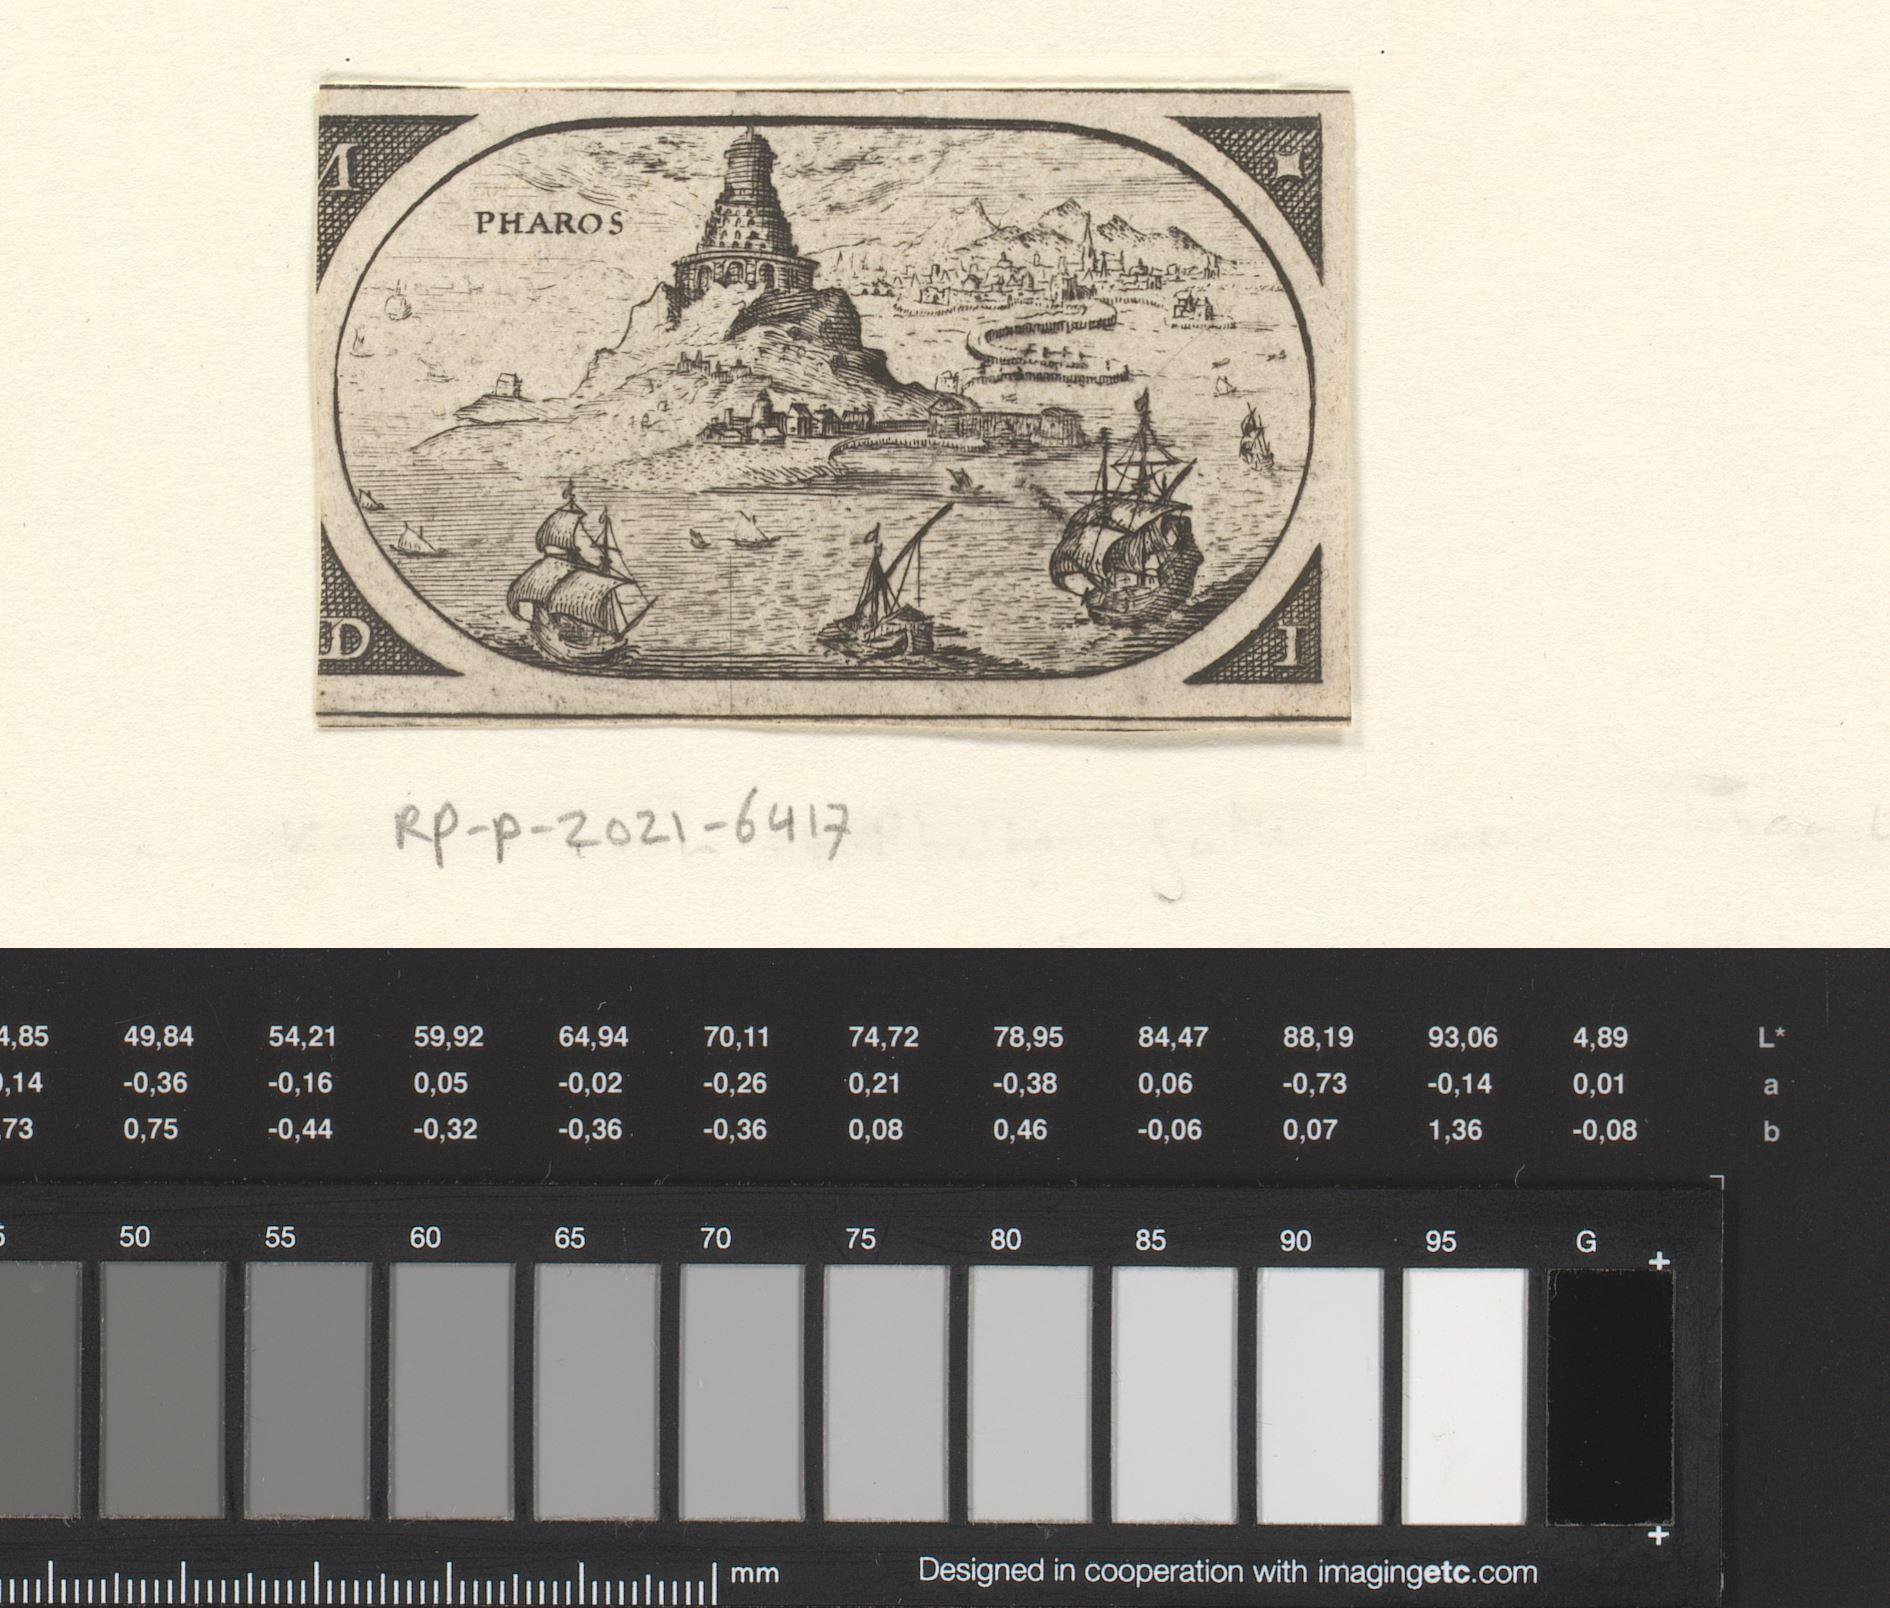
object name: print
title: Pharos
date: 1606-1656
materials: paper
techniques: engraving, etching, letterpress printing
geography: antwerp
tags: lighthouse, lightship, island (in tropical and sub-tropical regions), pharos of alexandria (wonder of the world)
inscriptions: collector's mark: Lugt 2228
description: De prent is afgesneden van de kaart 'Nova totius terrarum orbis geographica ac hydrographica tabula', voor het eerst in 1606 uitgegeven door Willem Janszoon Blaeu. De voorstellingen aan de onderkant van deze kaart zijn gekopieerd naar de serie 'De acht wereldwonderen', door Philips Galle naar Maarten van Heemskerck.